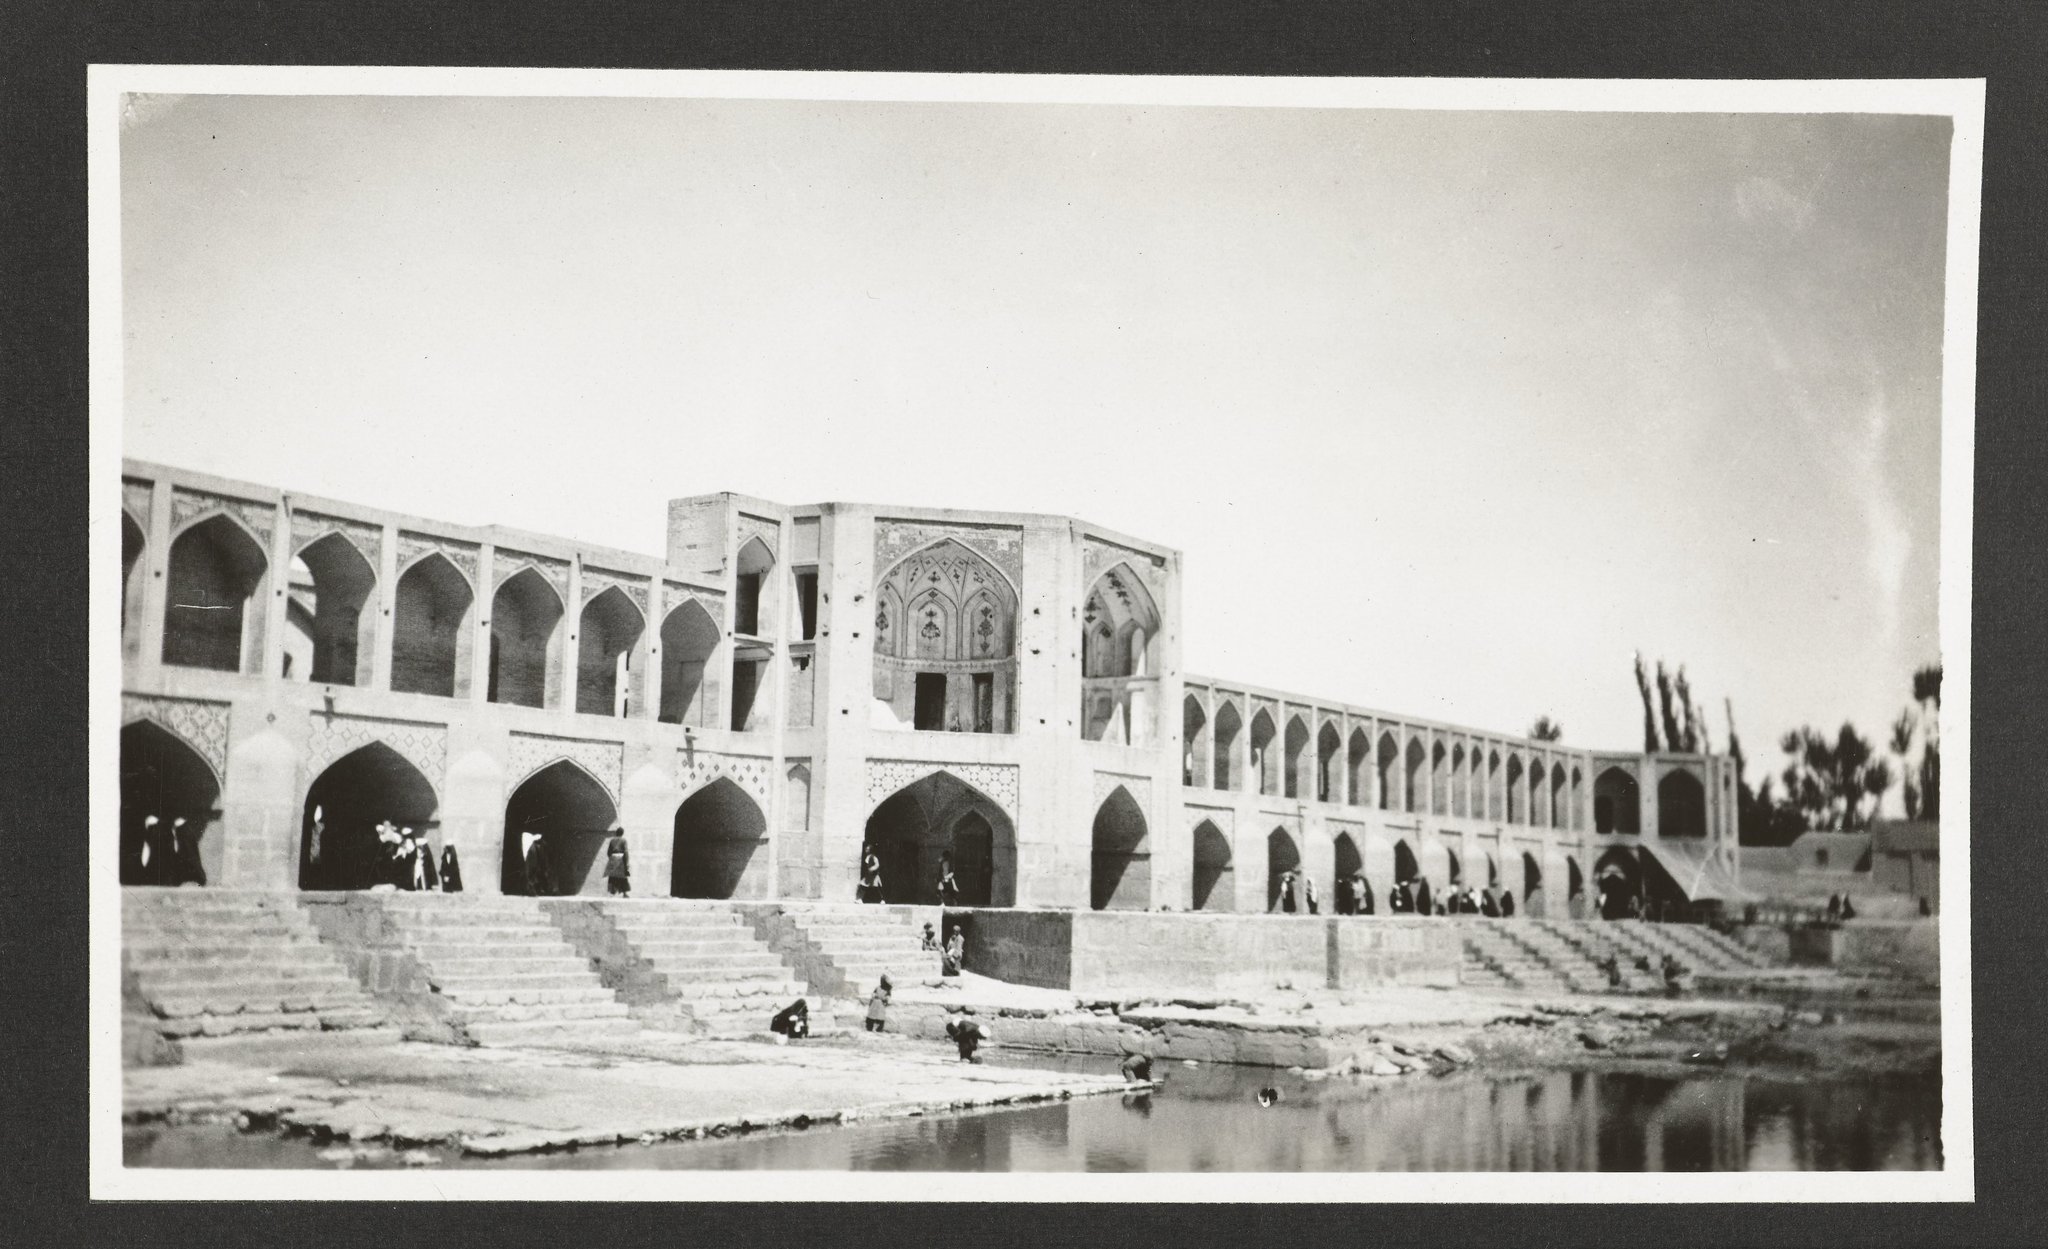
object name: photograph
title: Gezicht op de brug over Zendeh Rud, Isfahan, Perzië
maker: a.g.a. van eelde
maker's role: engineer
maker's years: 1862-1950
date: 1925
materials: cardboard, paper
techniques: gelatin silver print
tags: iran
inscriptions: number: ‘27.’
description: Titel op object afkomstig uit inventaris (Verklaring der Photo's) behorend bij het album.